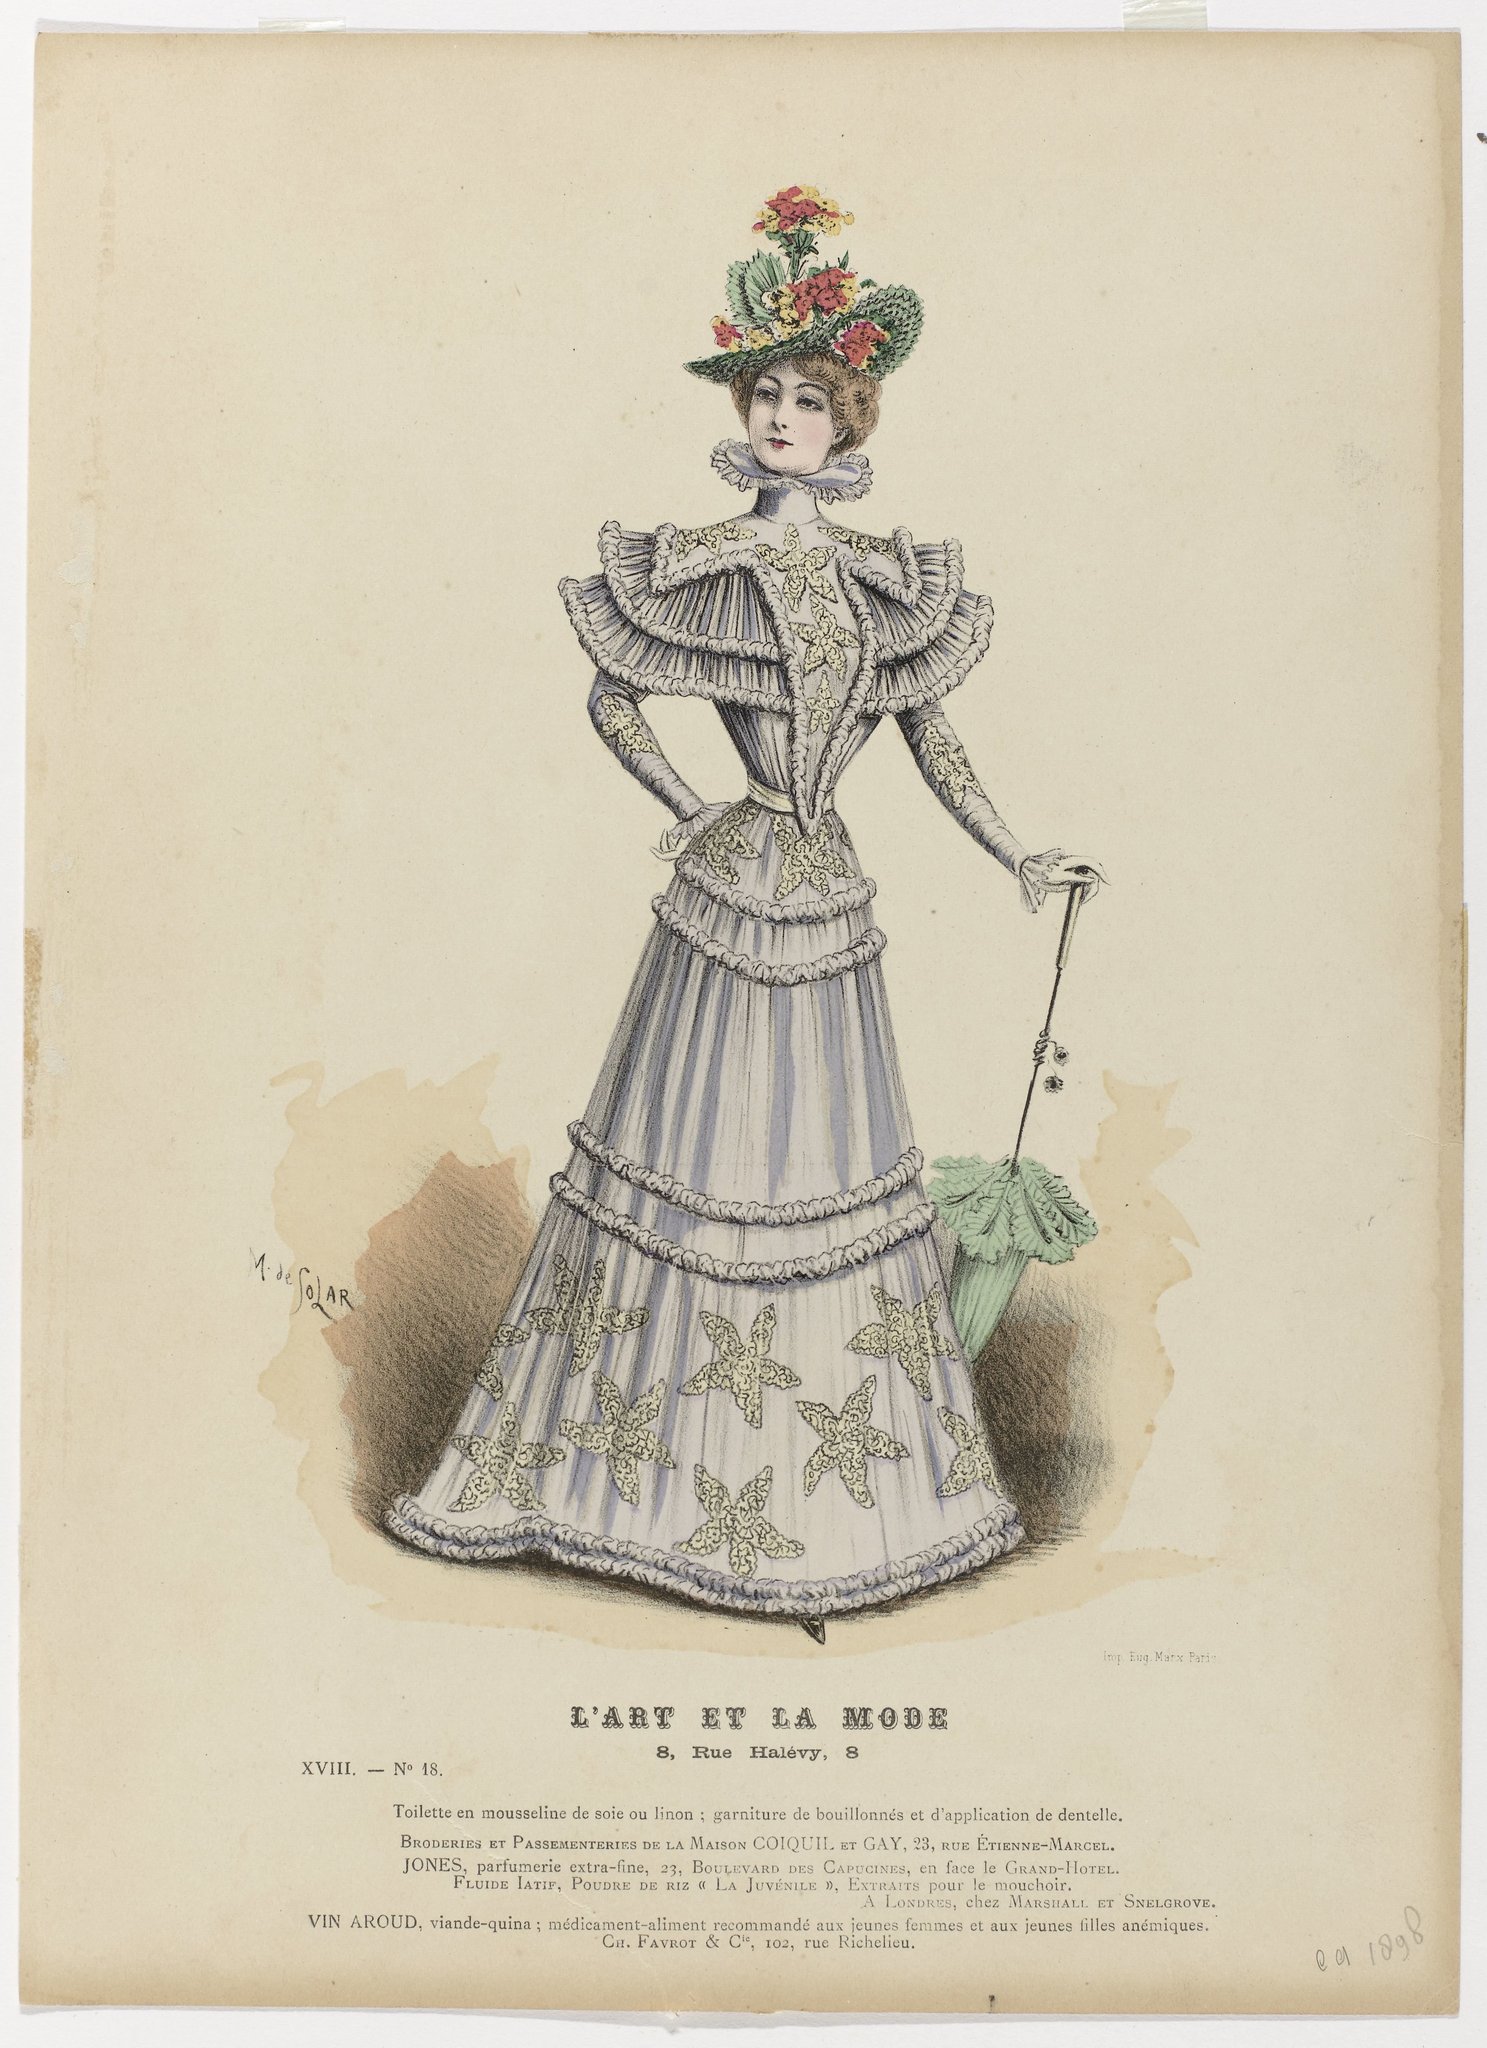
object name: fashion print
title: L'Art et la Mode, 1898, No. 18, XVIII: Toilette en mousselin (...)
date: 1898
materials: paper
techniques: hand coloring, lithograph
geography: paris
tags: flowers, lace (+ women's clothes), fashion plates, head-gear: hat (+ women's clothes), dress, gown (+ women's clothes), parasol, sunshade (+ women's clothes)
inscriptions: address: ‘8, Rue Halévy, 8’, caption: ‘Toilette en mousseline de soie ou linon; garniture de bouillonnés et d'application de dentelle. / BRODERIES ET PASSEMENTERIES DE LA MAISON COIQUIL ET GAY, 23, RUE ÉTIENNE-MARCEL. JONES, parfumerie extra-fine,23, BOULEVARD DES CAPUCINES, en face le GRAND-HOTEL. Fluide Iatif, POUDRE DE RIZ < La Juvénile> , Extraits pour le mouchoir. A Londres, chez MARSHALL ET SNELGROVE. / VIN AROUD, viande-quina; médicament-aliment recommandé aux jeunes femmes et aux jeunes filles anémiques. CH. FAVROT & CIE, 102, rue Richelieu.’, title: ‘L'ART ET LA MODE’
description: Staande vrouw gekleed in een 'toilette' van zijdemousseline of linnen. 'garnering de bouillonnés' (plooien) en stervormige applicaties van kant. Op het hoofd een hoed versierd met bloemen. Parasol in de hand. Onder de voorstelling enkele regels reclametekst voor verschillende producten. Prent uit het modetijdschrift L'Art et la Mode (1880-1967).